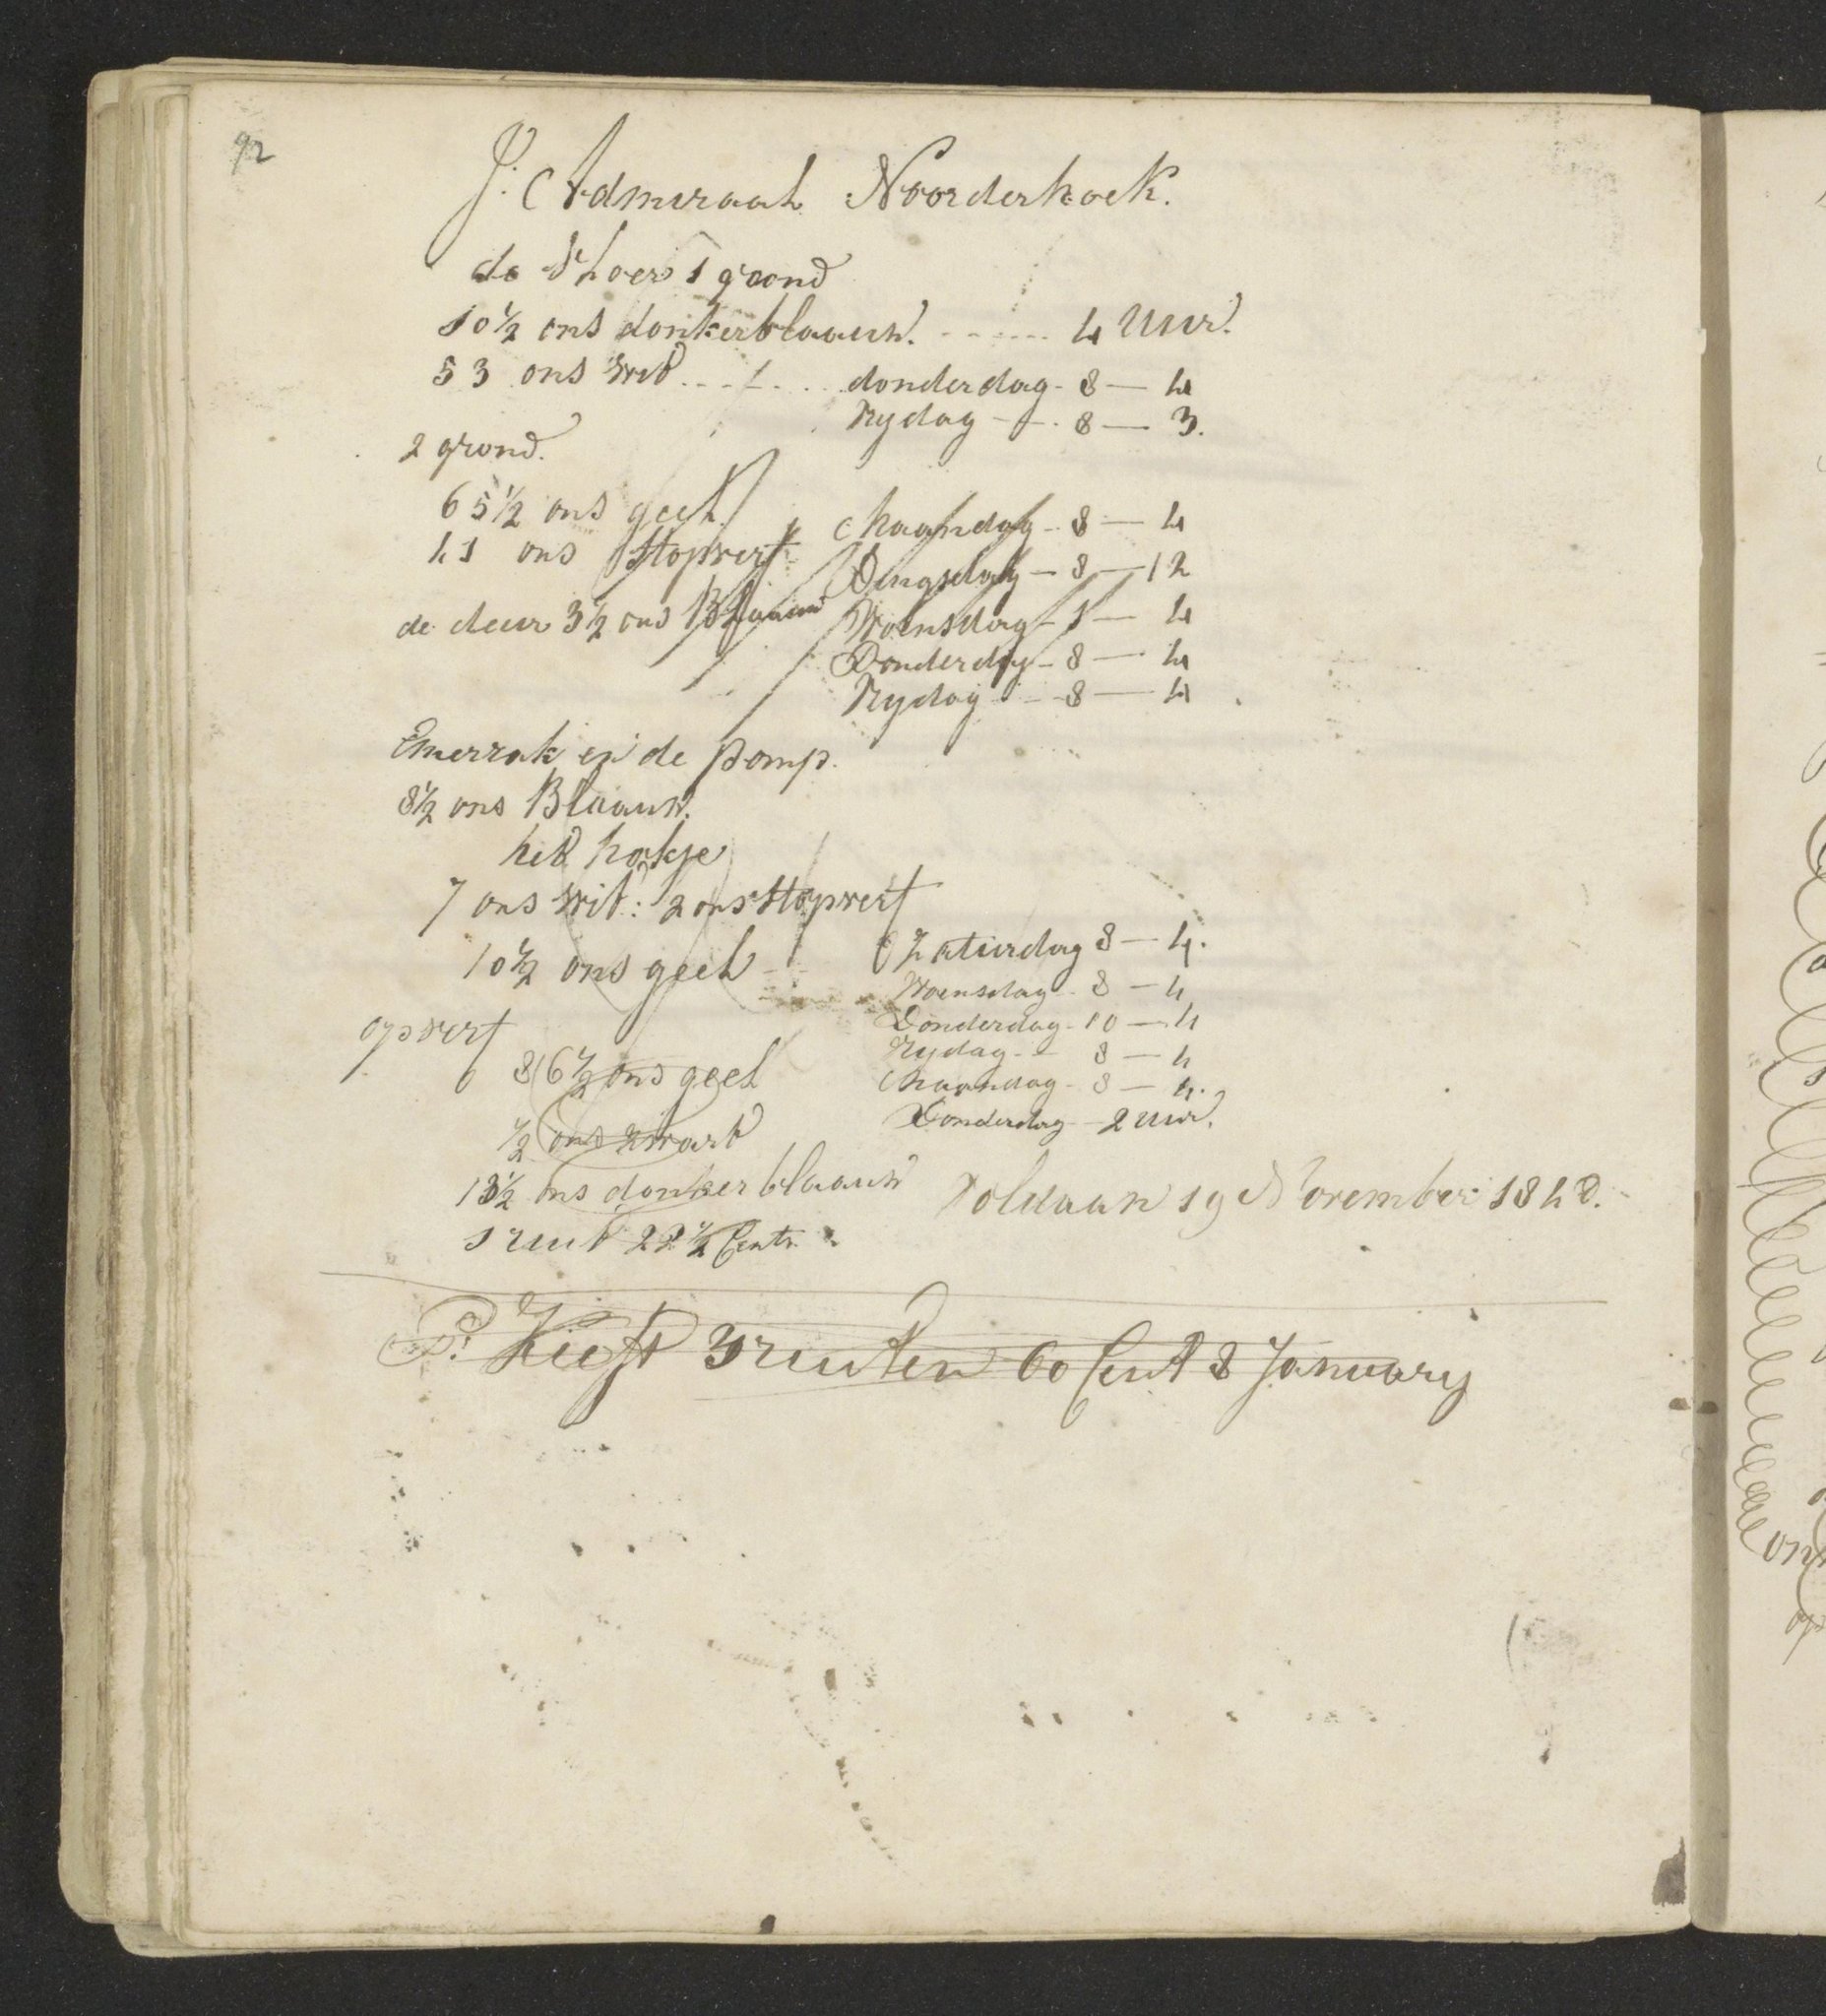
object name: sketchbook leaf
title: Kasboek met notities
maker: Anonymous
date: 1840-1860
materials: ink, paper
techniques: pen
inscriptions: annotation: ‘J: Admiraal Noorderhoek ...voldaan November 1848’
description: Kasboek van een schilder met notities over aangeschafte materialen. Bladzijde 92 uit een schetsboek met 96 bladzijden.